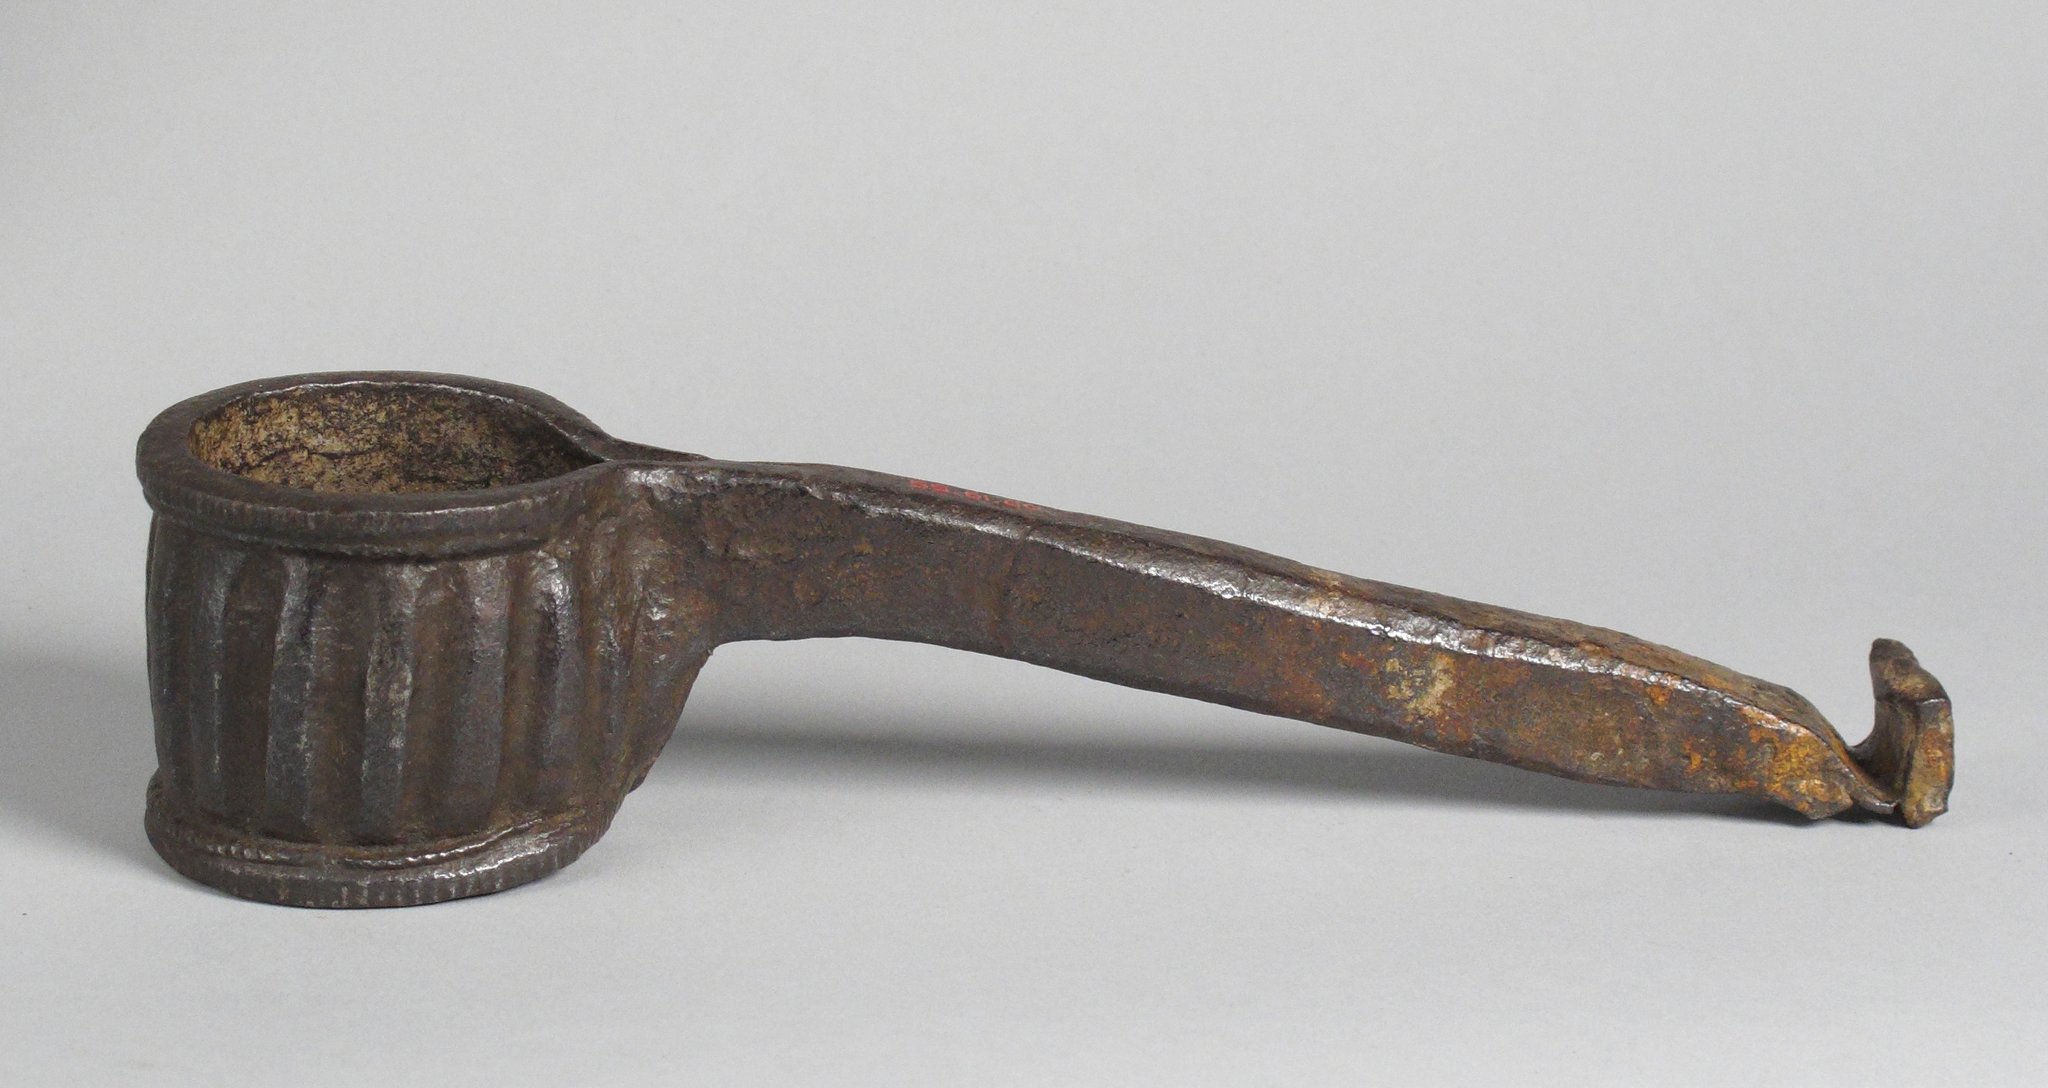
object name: torch holder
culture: european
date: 1401-1600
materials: iron